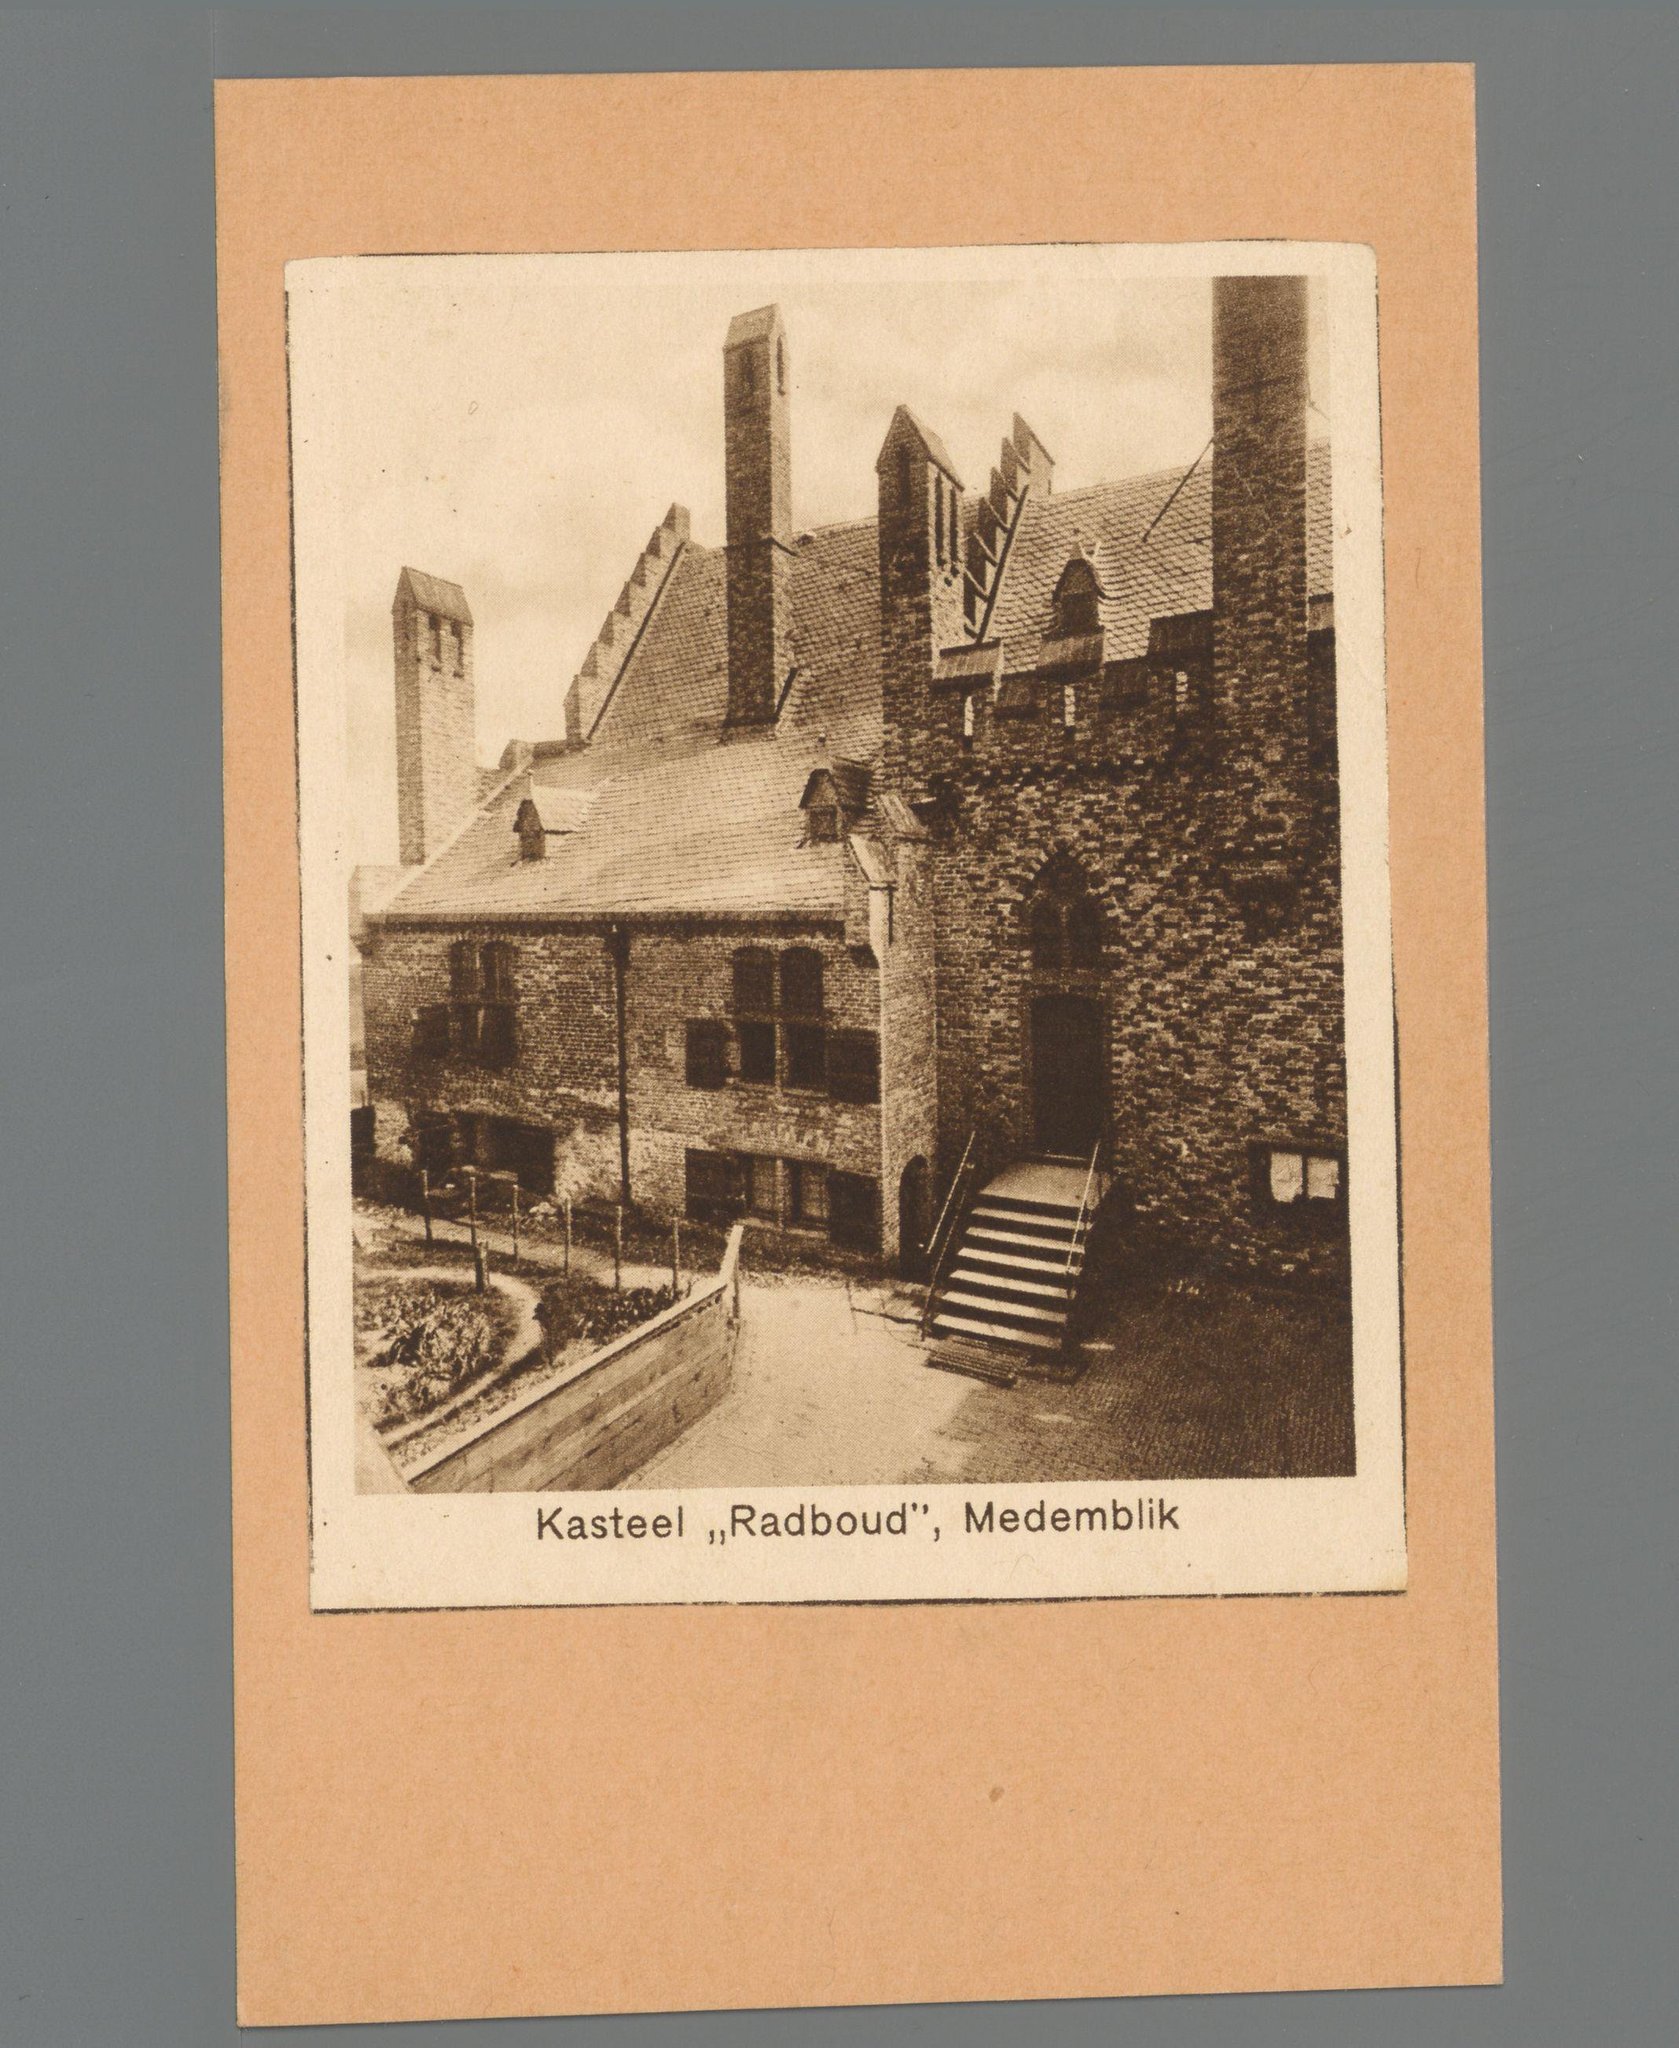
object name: ansichtkaart, prentbriefkaart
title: Kasteel "Radboud", Medemblik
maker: Anonymous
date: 1895-1930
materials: cardboard, paper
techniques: rotogravure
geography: medemblik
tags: castle